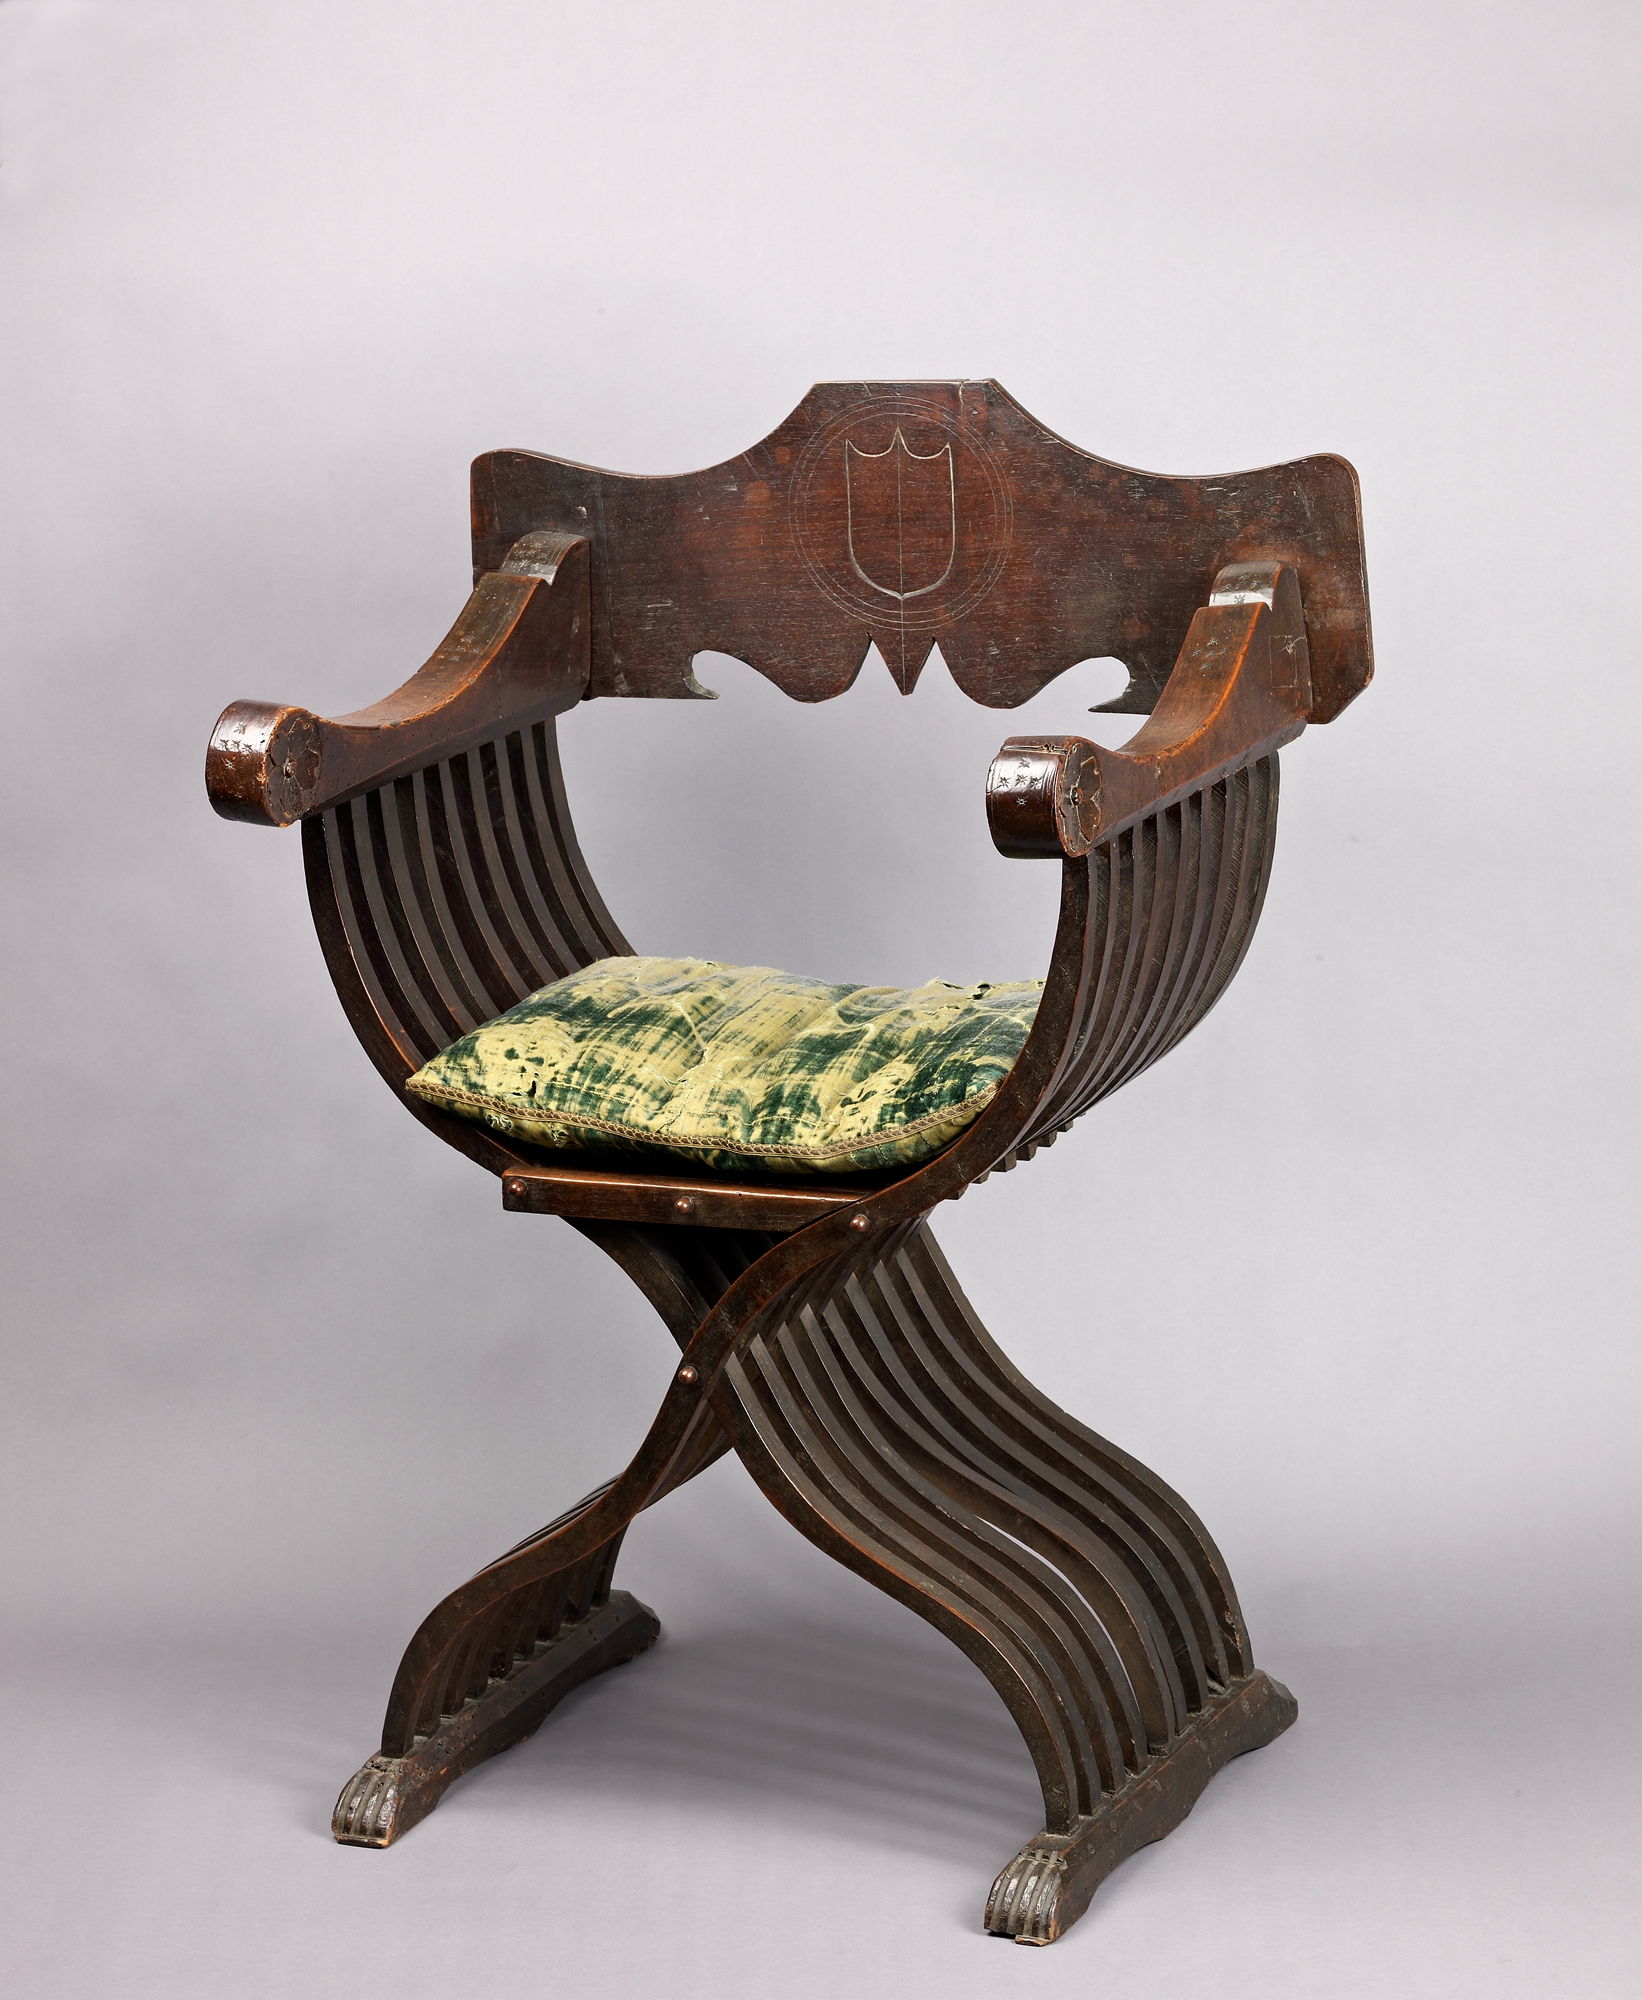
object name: armchair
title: Folding armchair (sedia a Savonarola type)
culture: italian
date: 1401-1500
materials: velvet, wood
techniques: carving